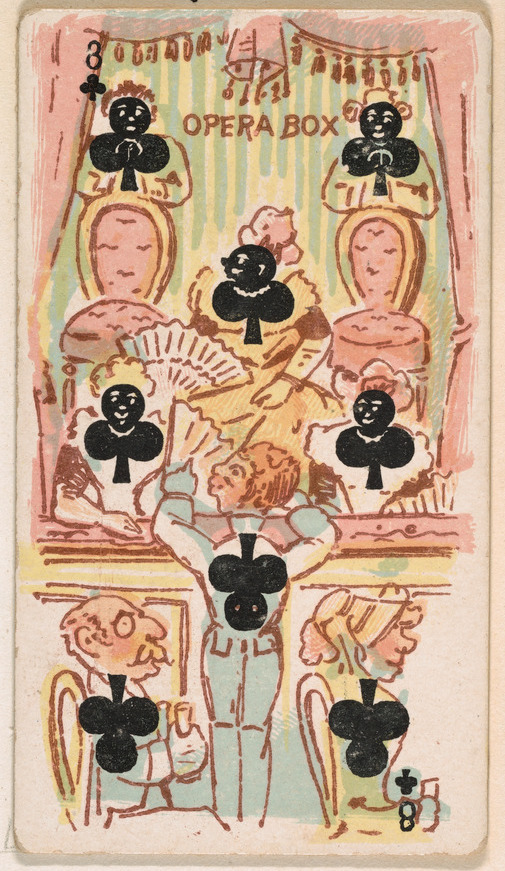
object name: print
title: Eight of Clubs, Opera Box, from Harlequin Cards, 2nd Series (N220) issued by Kinney Bros.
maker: kinney brothers tobacco company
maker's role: publisher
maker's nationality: american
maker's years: 1869-2011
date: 1889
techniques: color lithograph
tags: playing cards